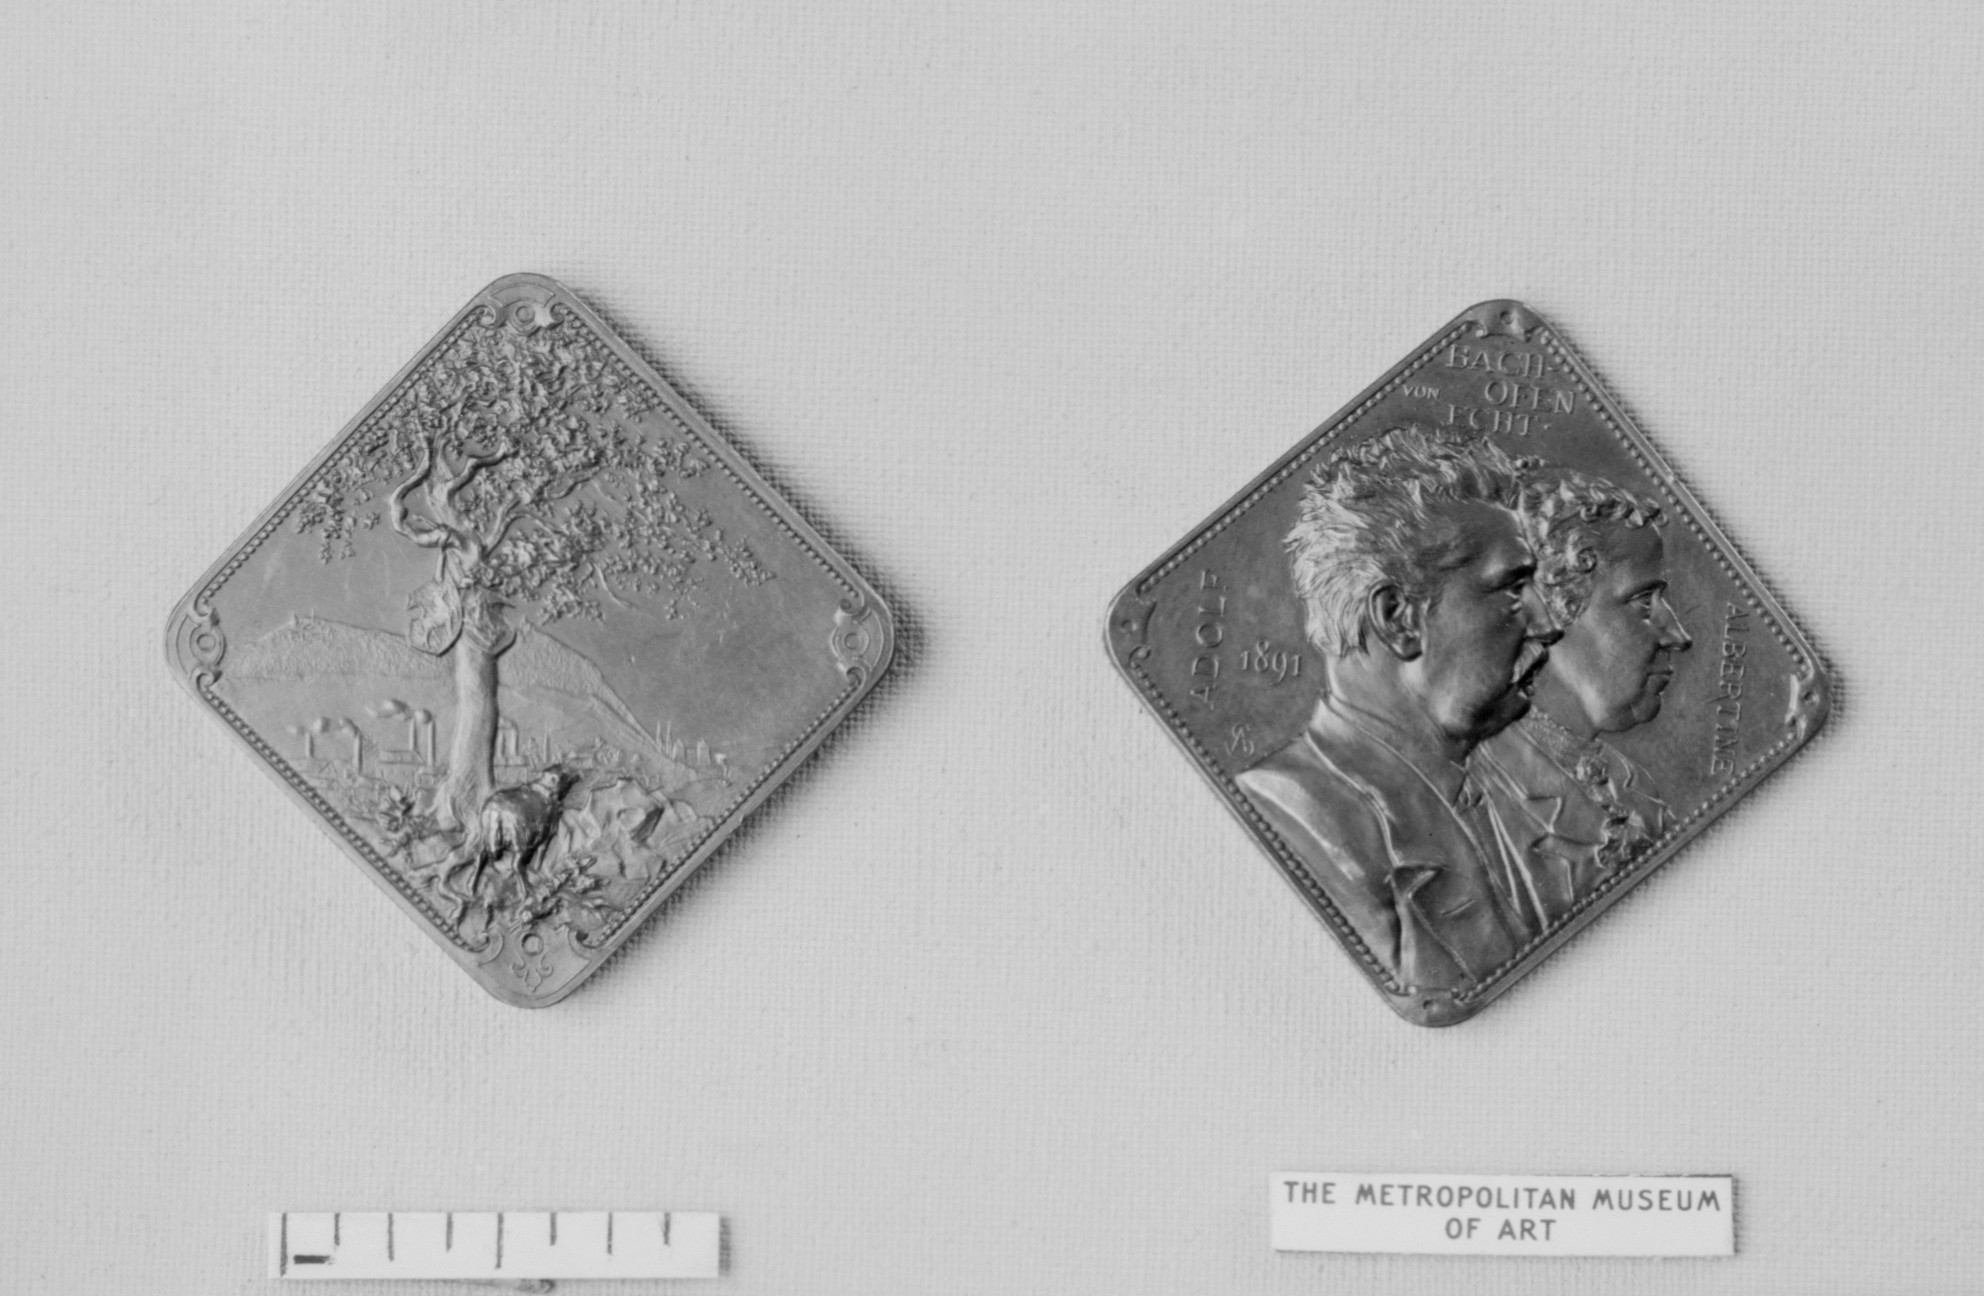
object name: plaquette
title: Adolf and Albertine Bachofen von Echt, 1891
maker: anton scharff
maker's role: artist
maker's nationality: austrian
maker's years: 1845-1903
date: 1891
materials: bronze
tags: animals,men,profiles,trees